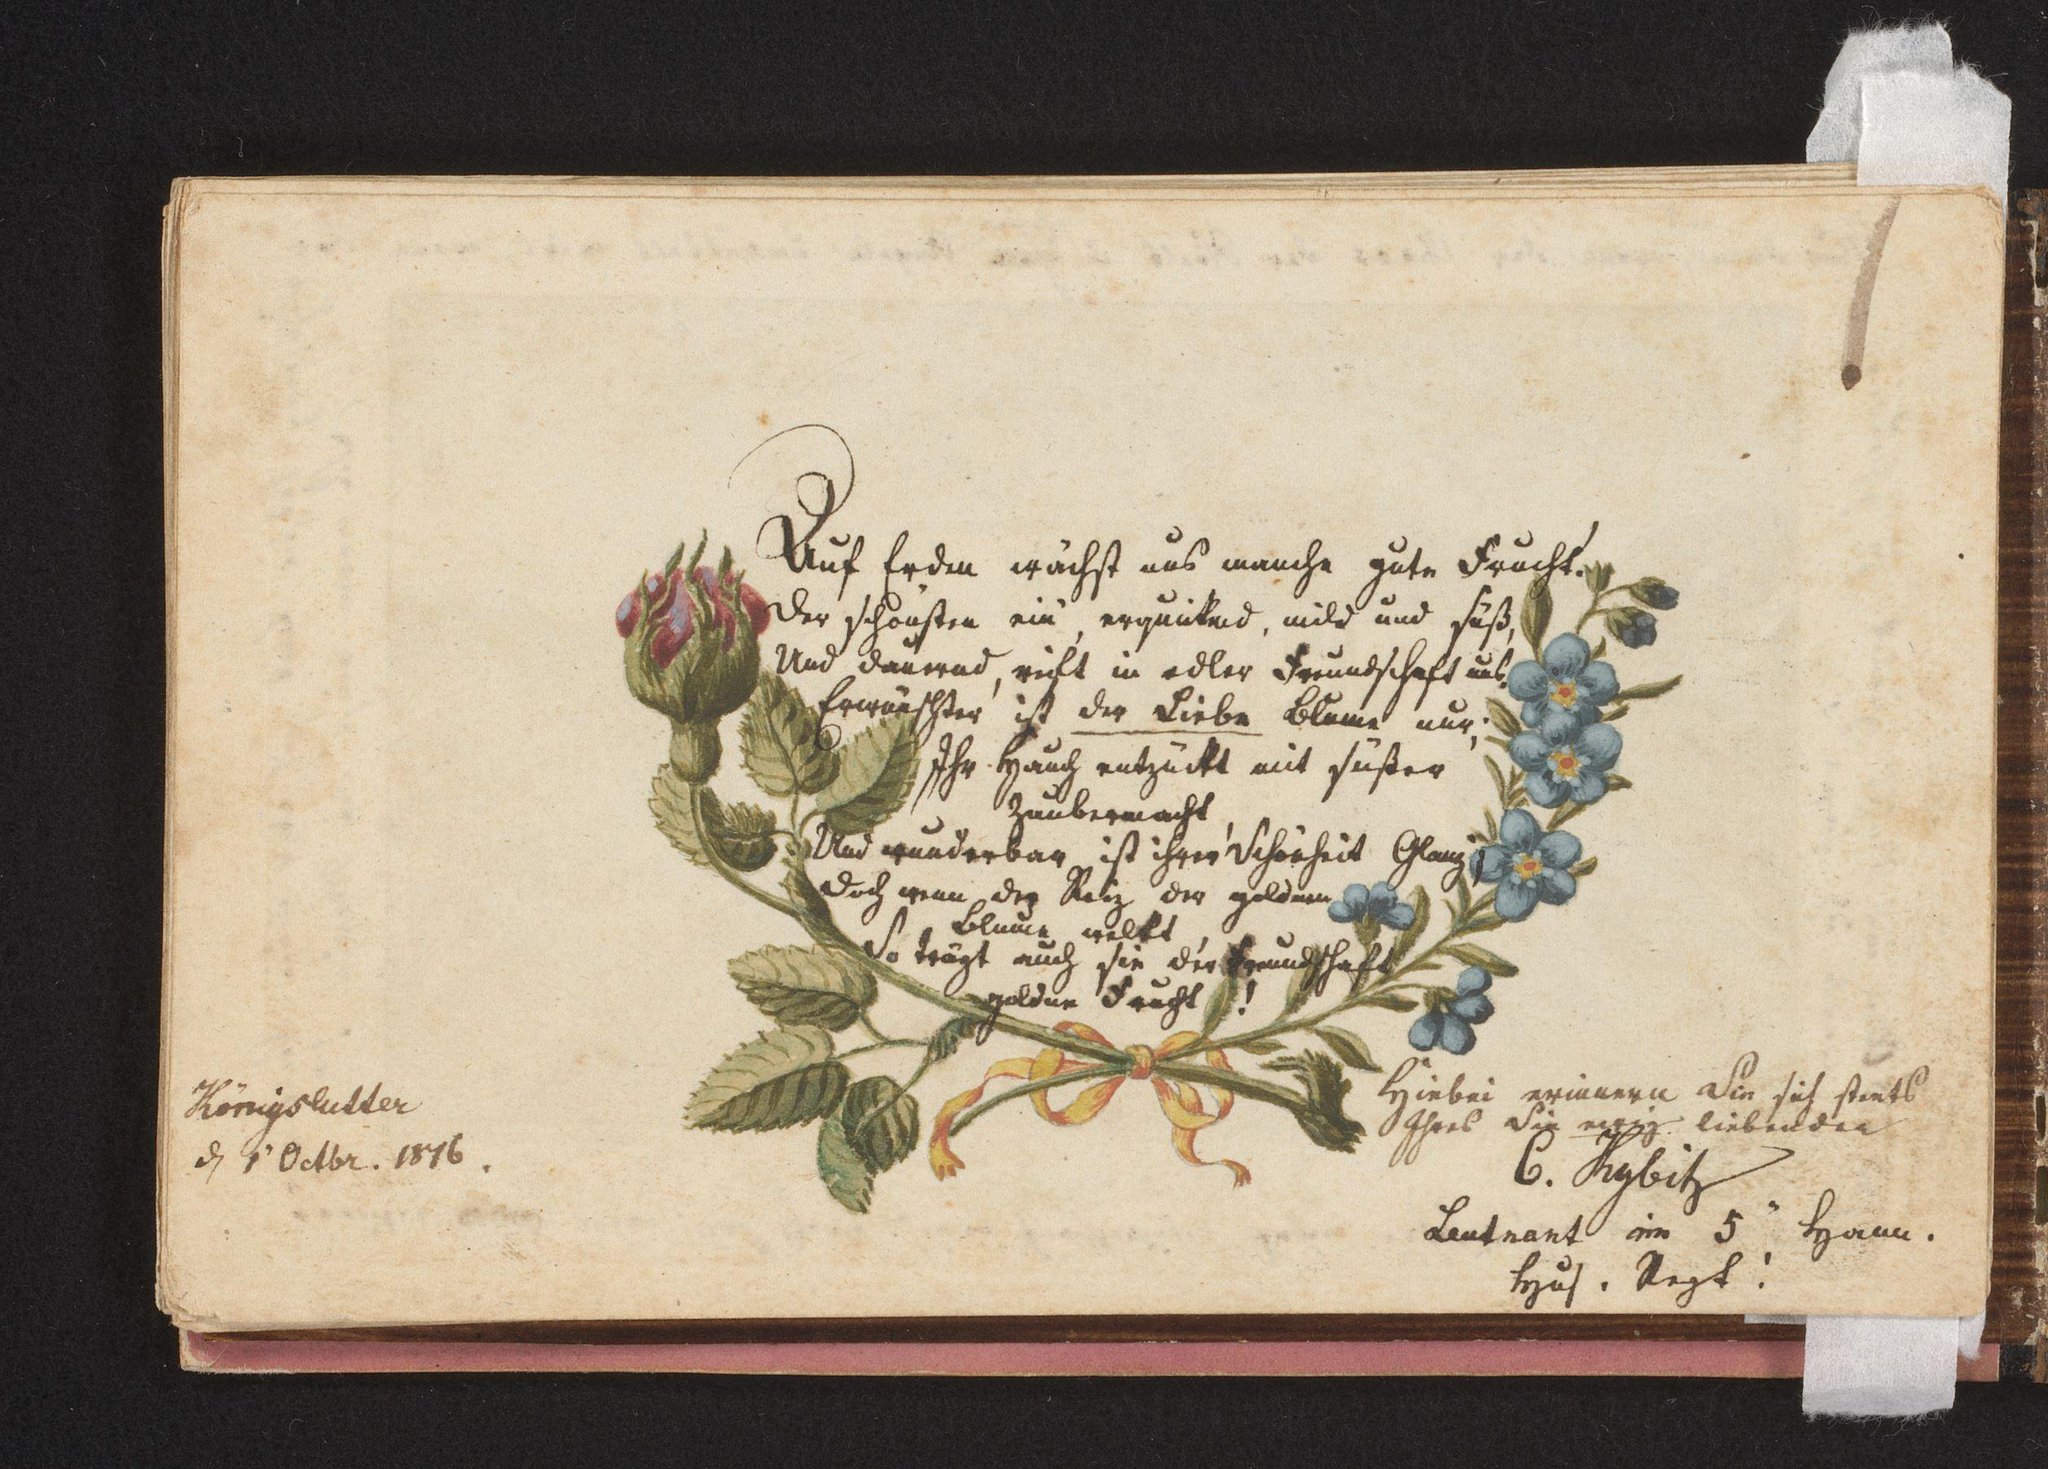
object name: print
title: Tekst boven een bij elkaar gebonden roos en vergeet-me-nietje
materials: paint, ink, paper, watercolor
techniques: brush, pen, writing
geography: gottingen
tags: floral interlace ~ ornament, 'album amicorum', 'stammbuch'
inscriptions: tekst, verso, handgeschreven